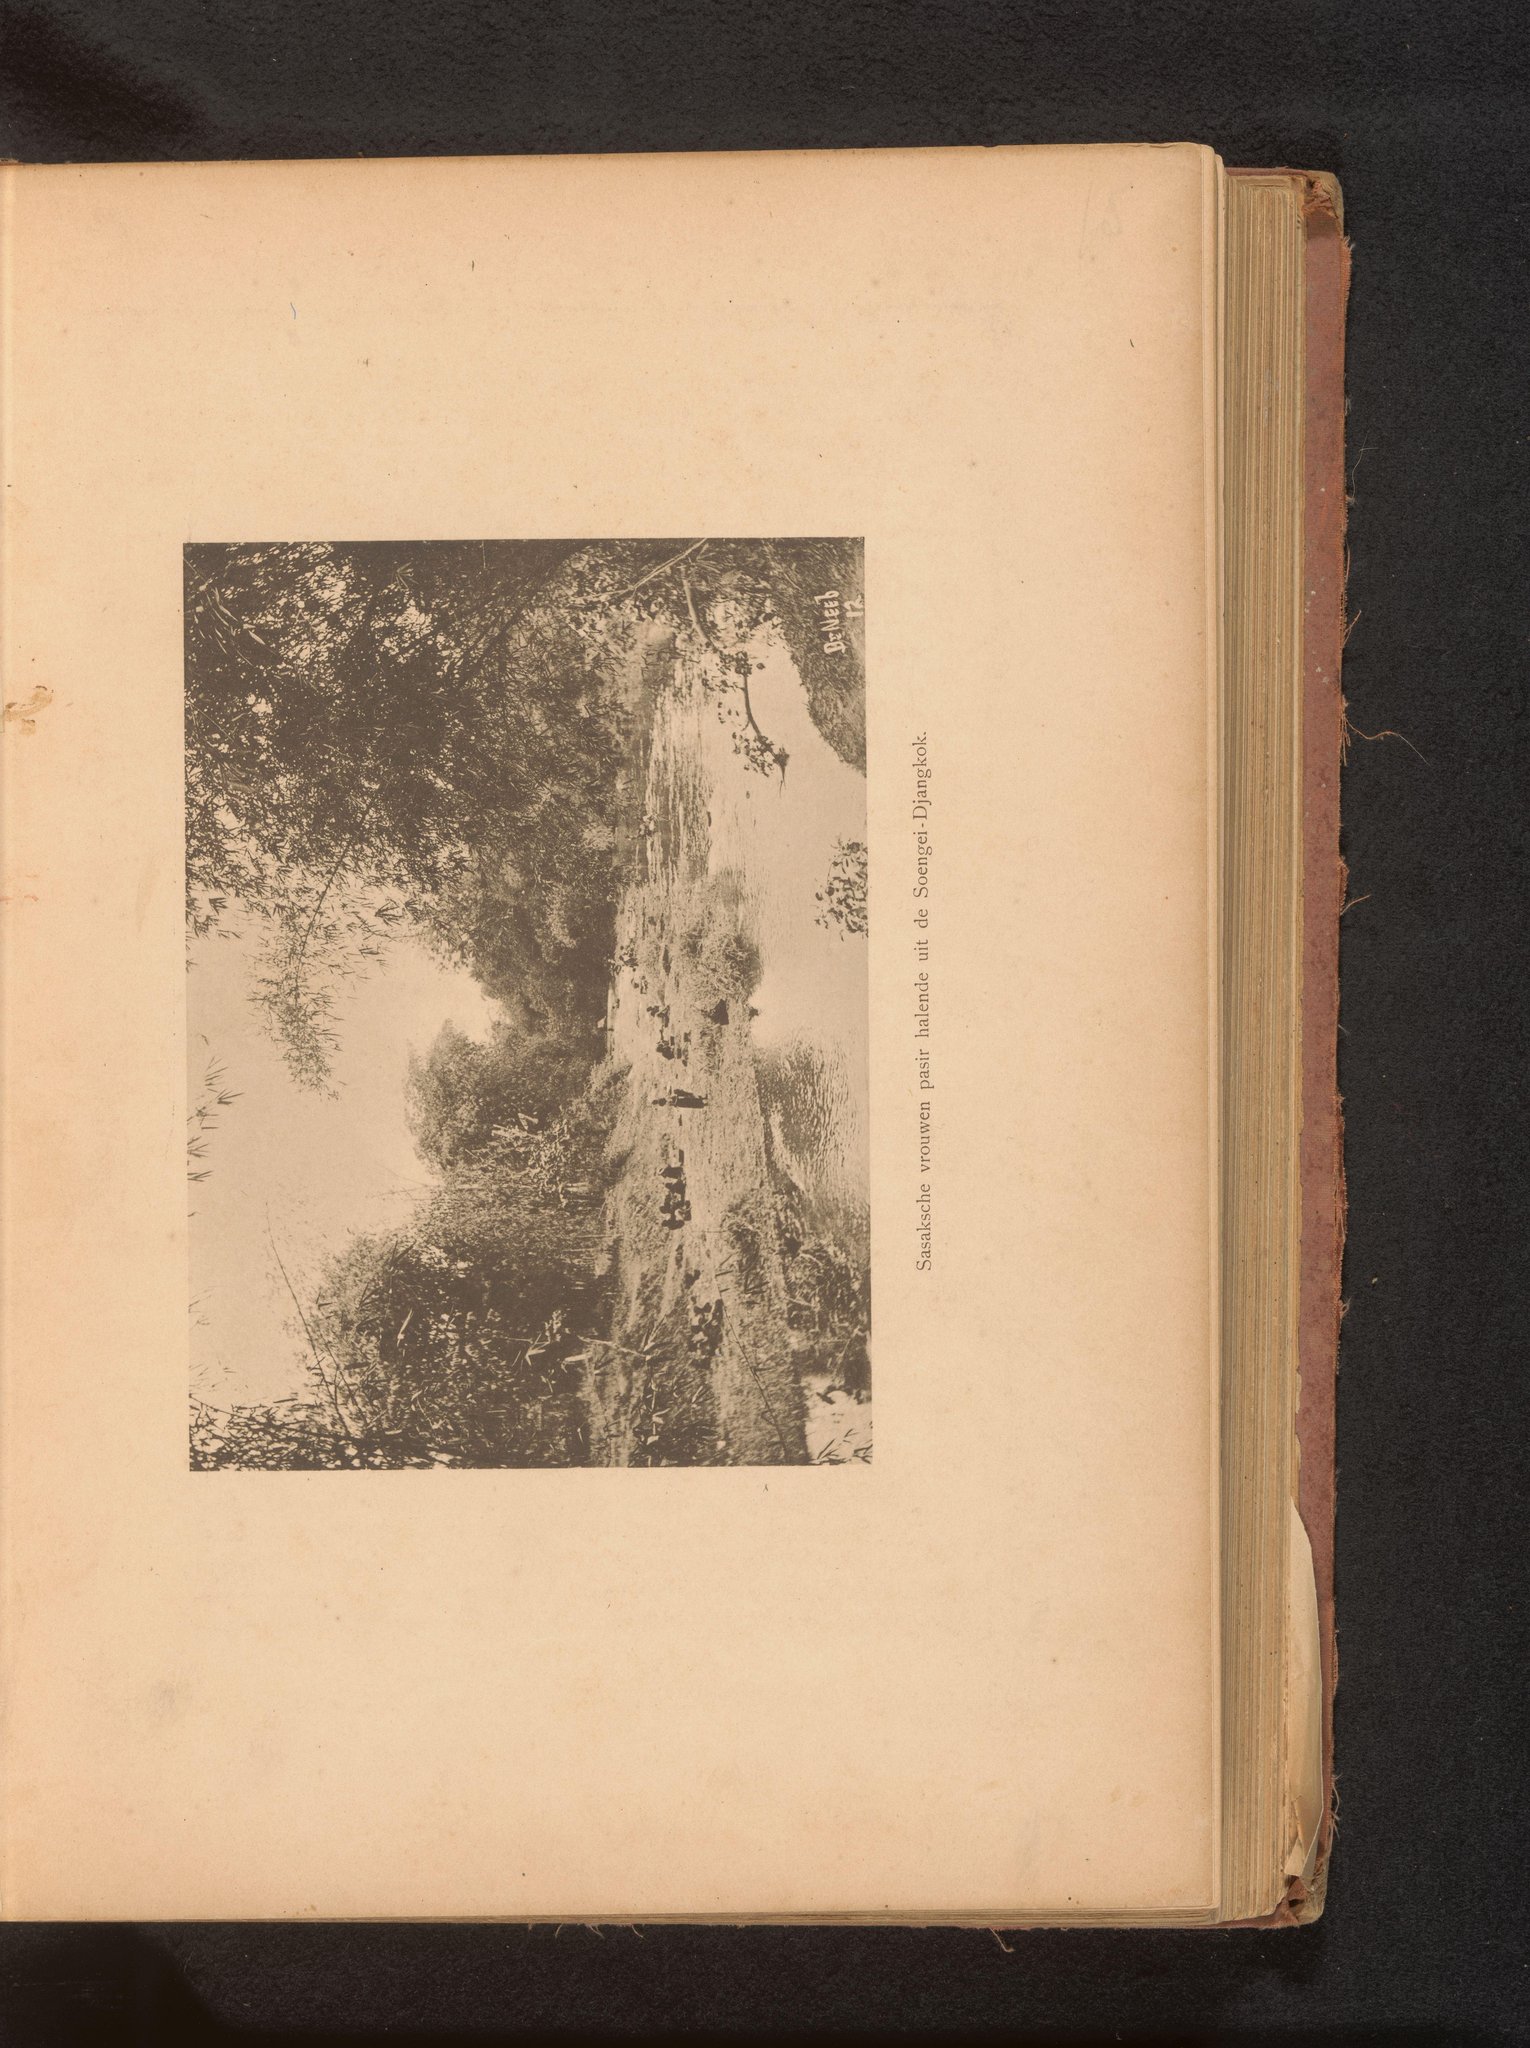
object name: page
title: Sasaksche vrouwen pasir halende uit de Soengei-Djangkok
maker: christiaan johan neeb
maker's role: arts, fotograaf, officier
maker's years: 1860-1925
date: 1892-1897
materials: paper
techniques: photograph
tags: adult woman, river, river bank